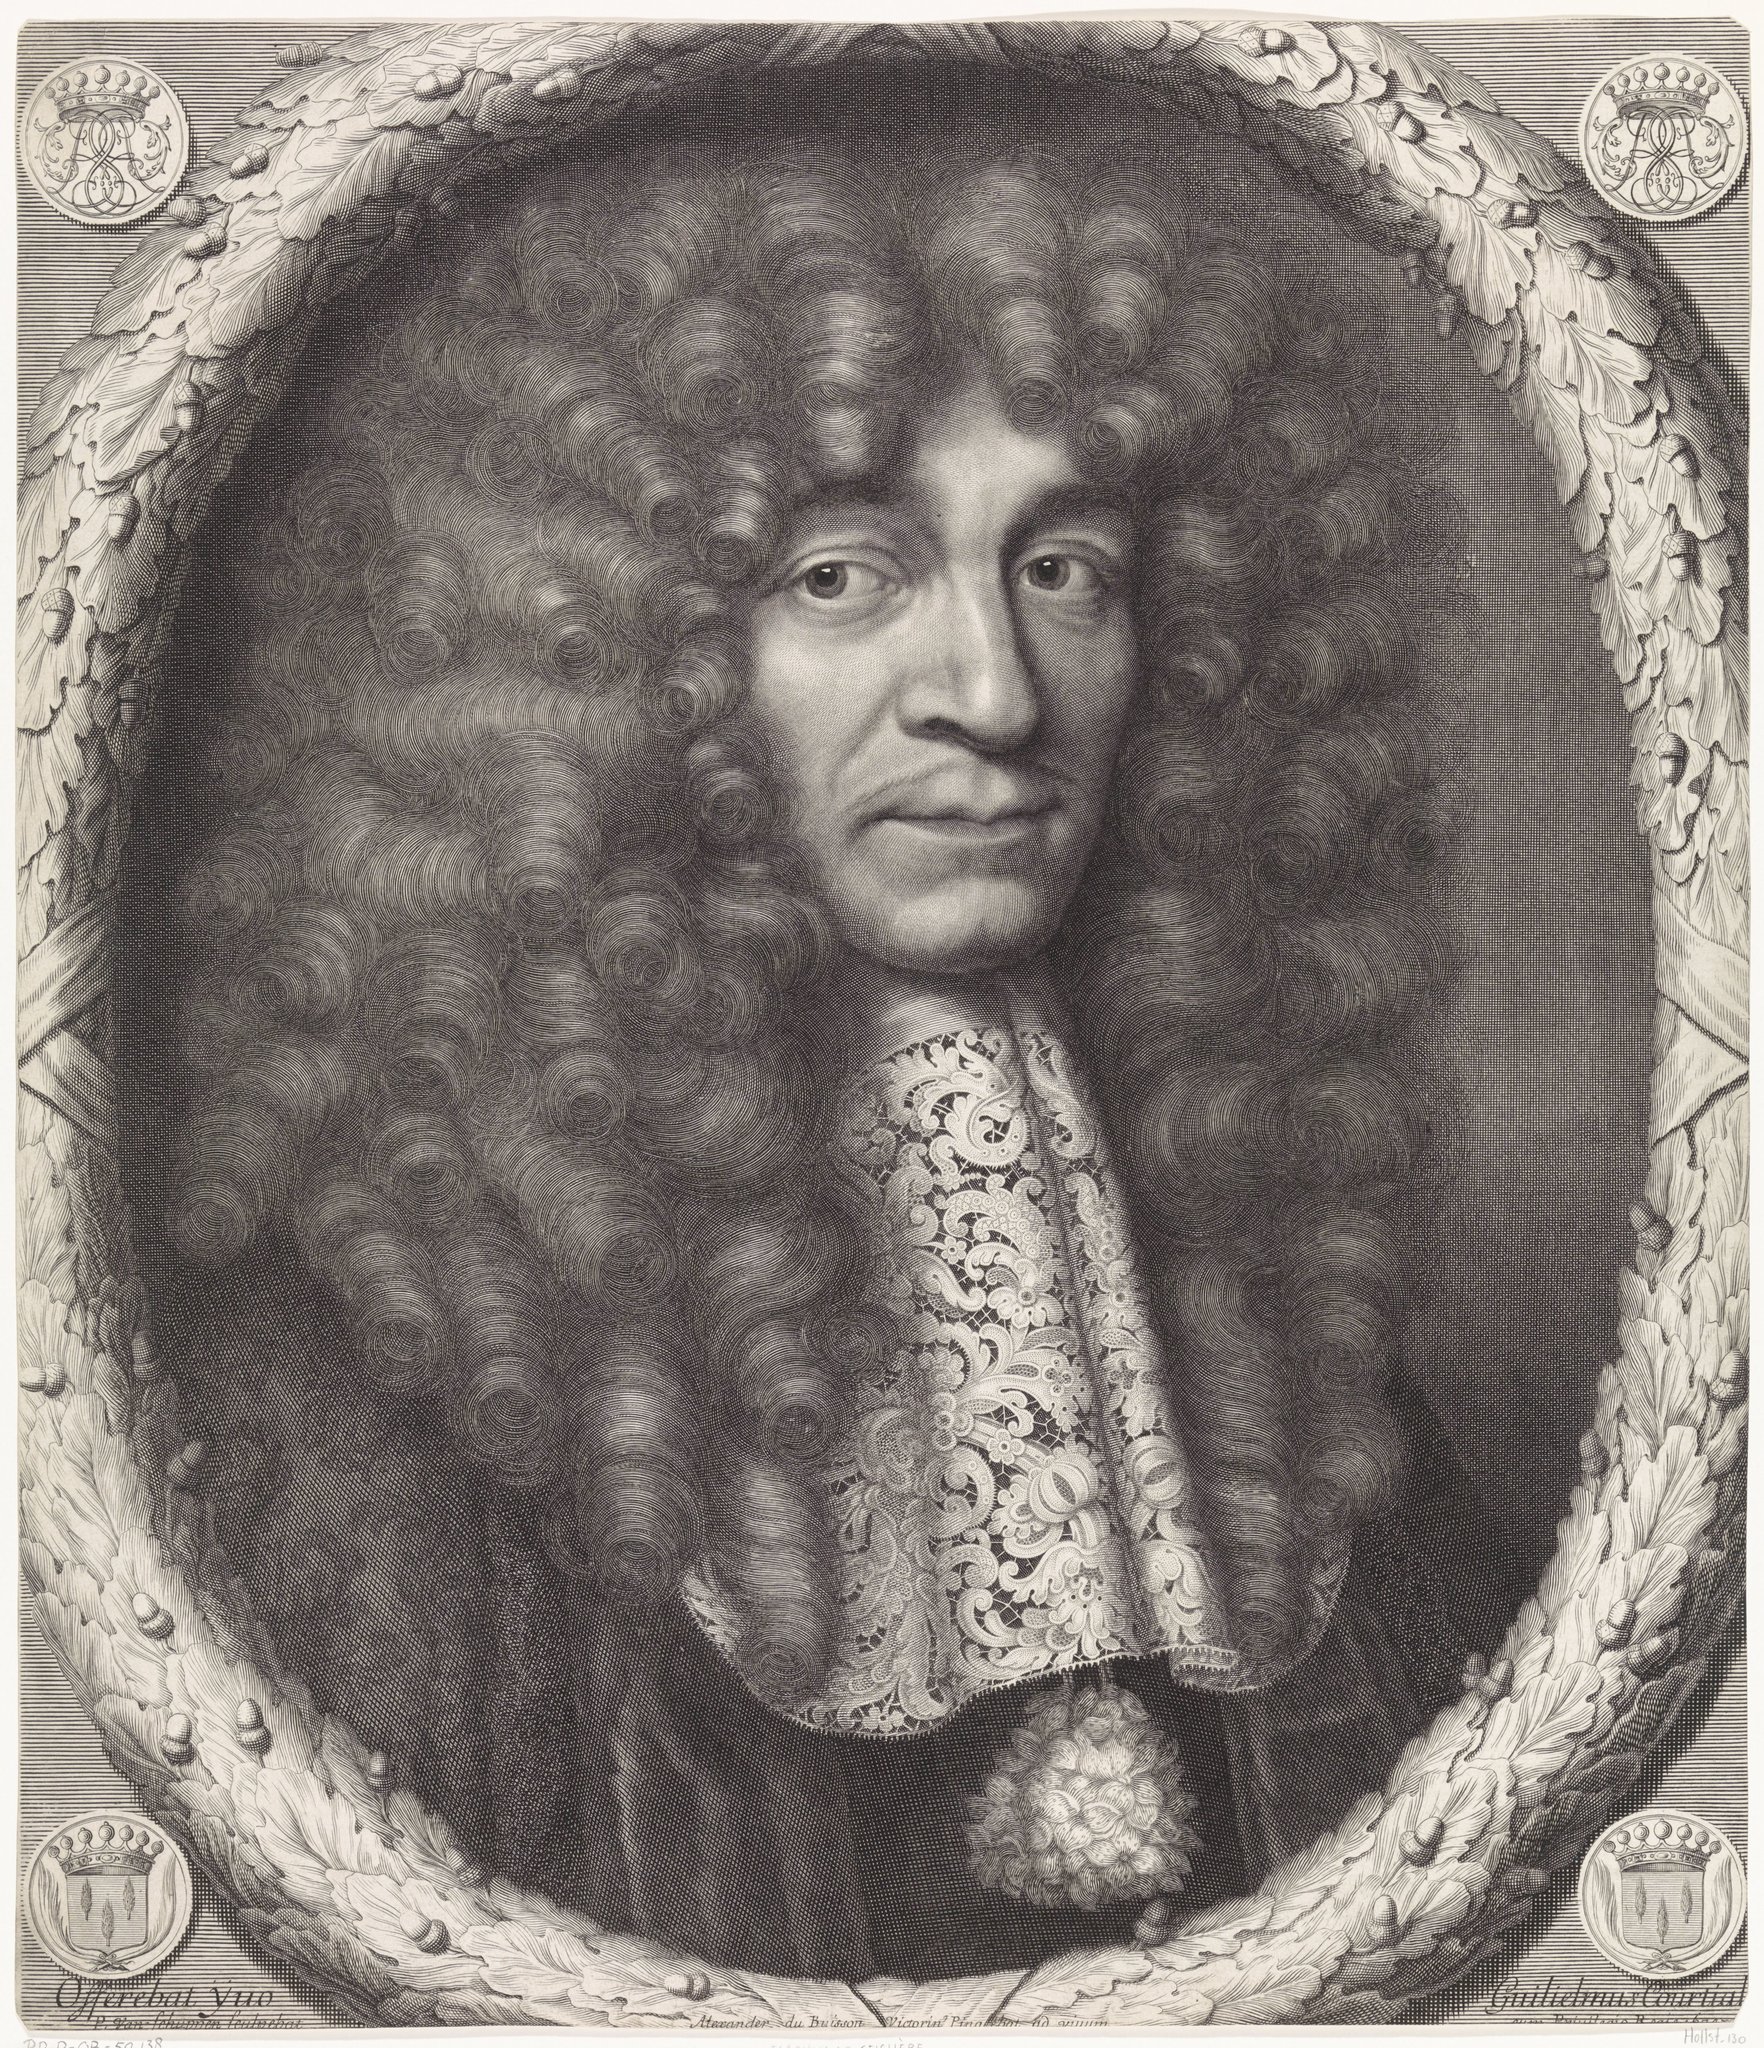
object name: print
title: Portret van Joachim de Seiglière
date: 1674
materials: paper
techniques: engraving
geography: paris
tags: joachim adolphe seiglière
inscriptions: collector's mark: Lugt 240